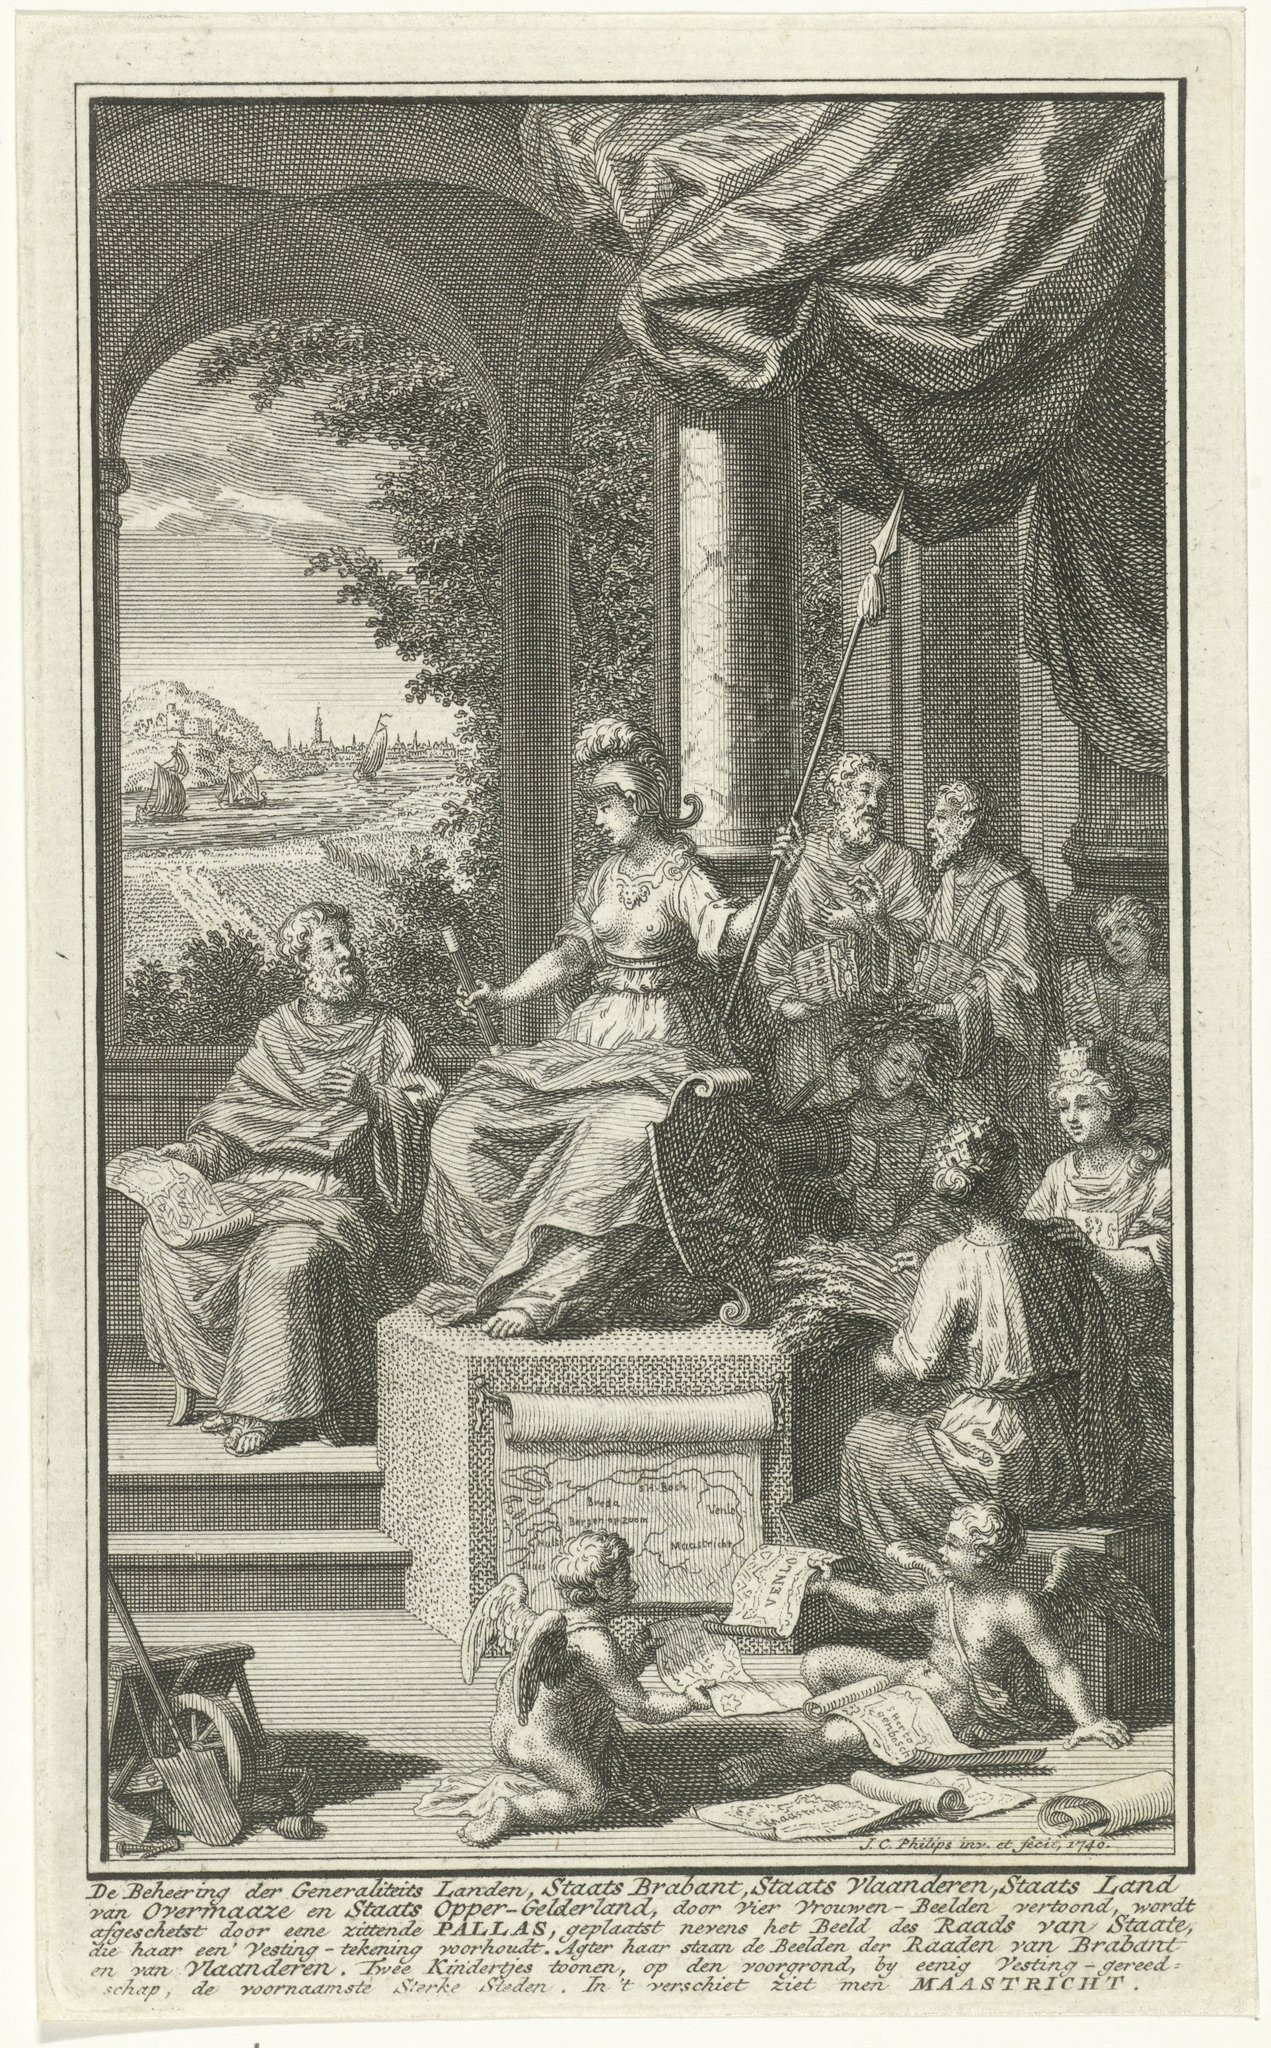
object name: titelblad, titelpagina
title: Titelpagina voor: J. Wagenaar, Tegenwoordige staat der Vereenigde Nederlanden, 1740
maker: jan caspar philips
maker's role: draughtsman, print maker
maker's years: 1700-1775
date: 1740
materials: paper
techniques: engraving, etching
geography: amsterdam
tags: personifications of countries, nations, states, districts, etc., (story of) minerva (pallas, athena), maps, atlases, maastricht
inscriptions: collector's mark: Lugt 2228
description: Vertrek met vier vrouwen die de Generaliteitslanden symboliseren en Minerva, in gesprek met een lid van de Raad van State. Op de voorgrond putti met landkaarten van de gebieden. Op de achtergrond een gezicht op Maastricht. In de marge een zesregelig onderschrift in het Nederlands.